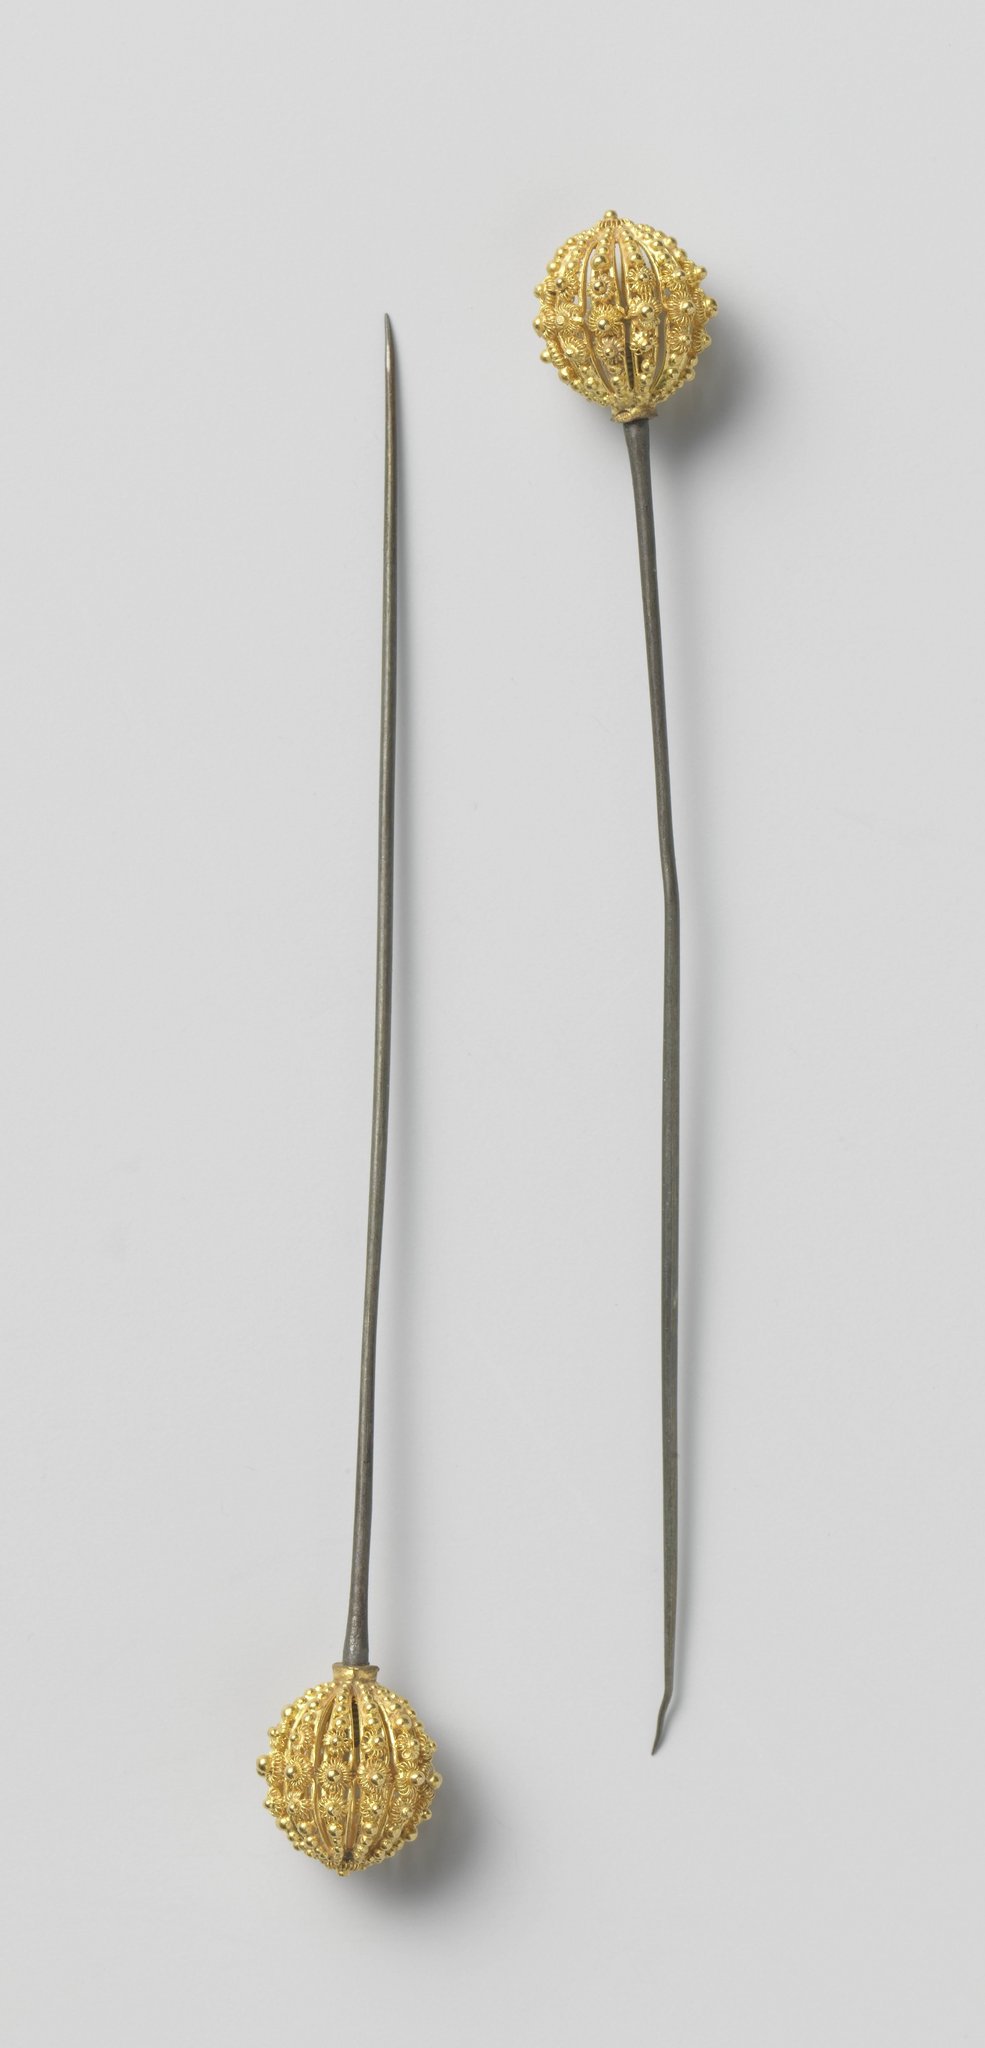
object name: haarnaald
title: Stel haarnaalden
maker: Anonymous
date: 1824-1840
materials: gold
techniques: filigree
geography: netherlands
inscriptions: alloy mark: ‘585 in ovaal (Nederland, vanaf 1955)’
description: Parure. Gold. Amsterdam, c. 1824 - 1838, by Guillaume Louis Ploem, C. Charles Colsoul en Johan Lorenz Holzapfel.